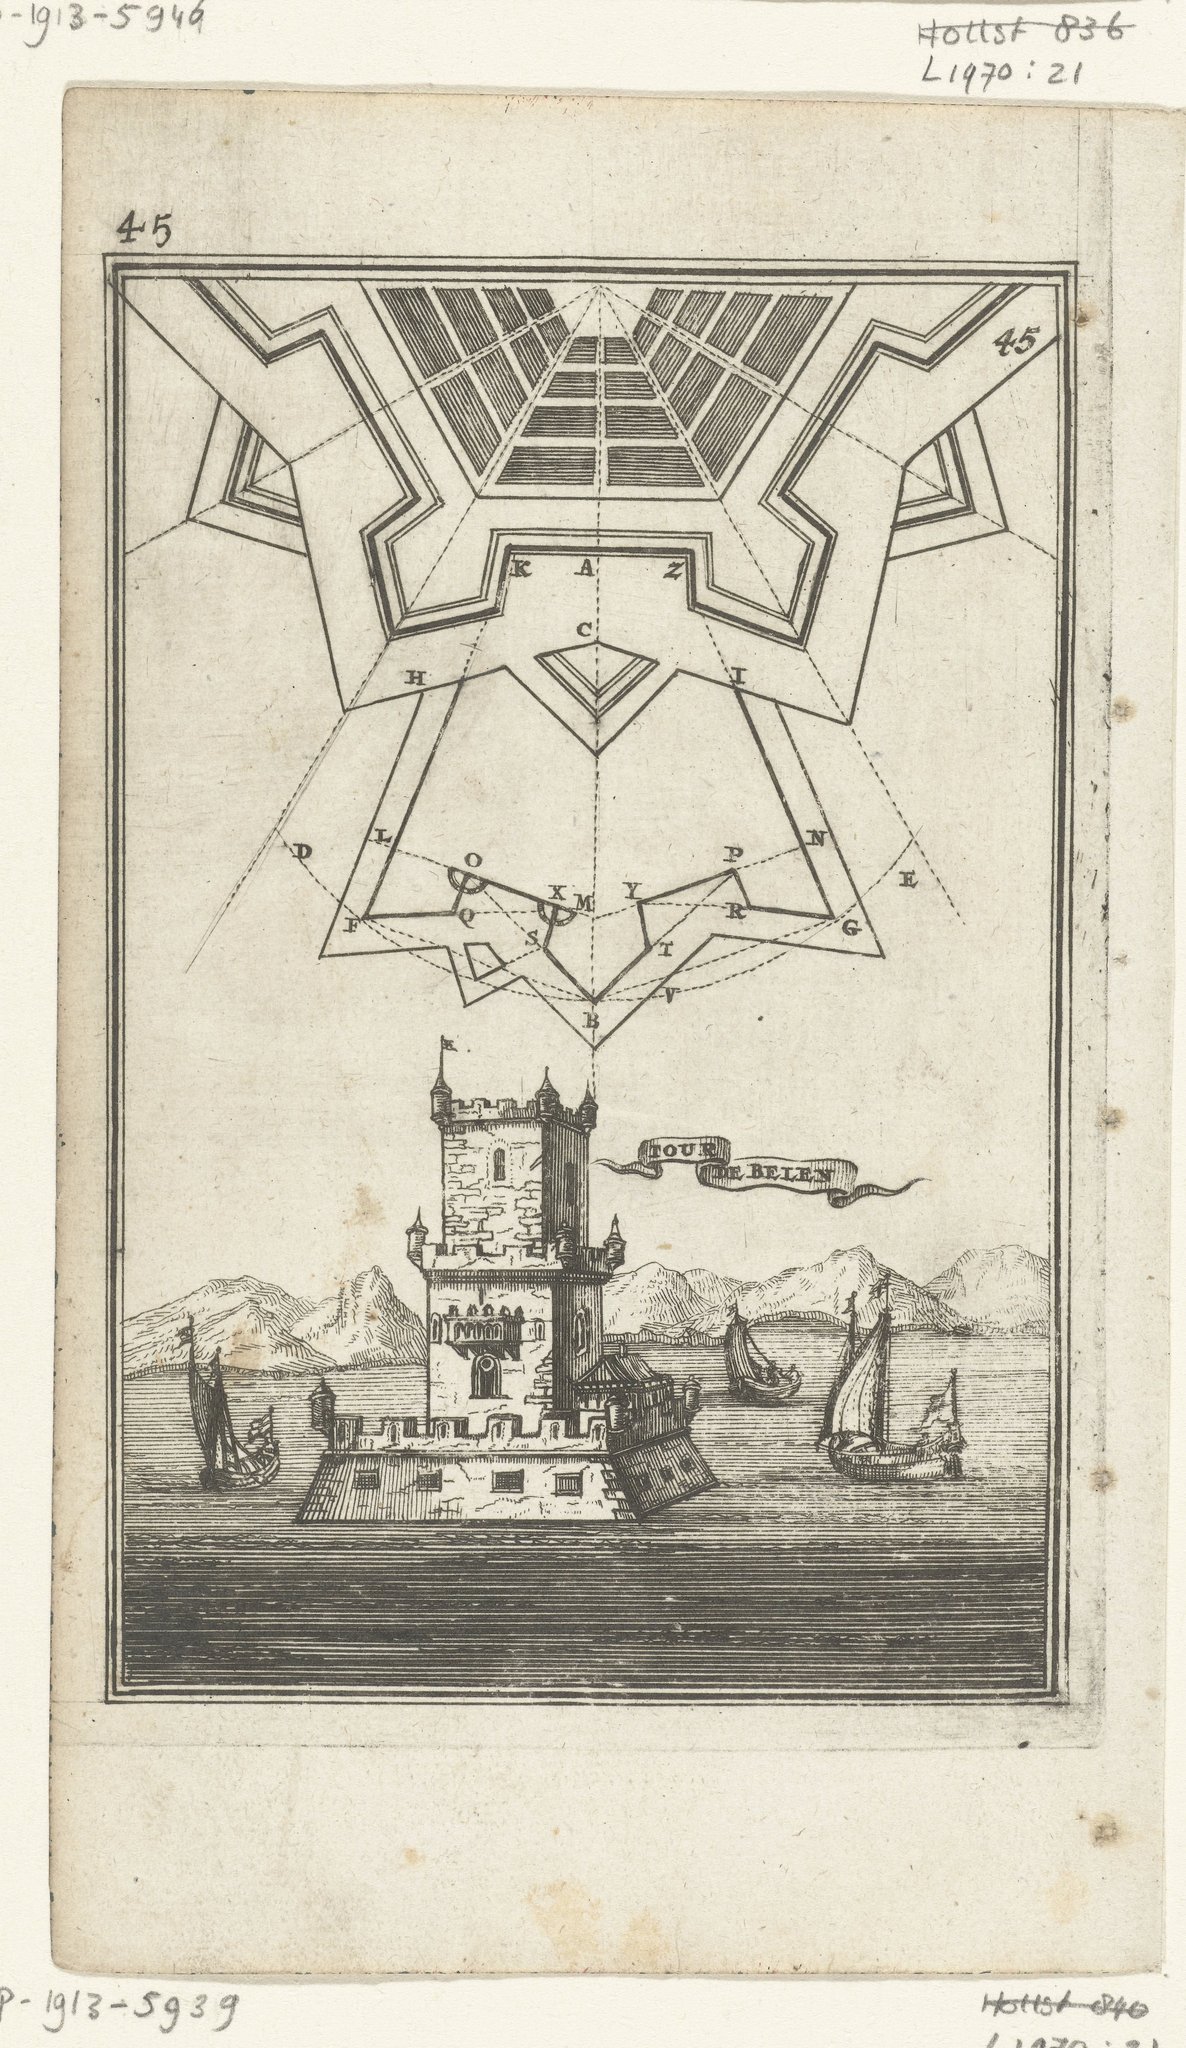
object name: book illustration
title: Illustratie voor 'Den Arbeid van Mars' van Allain Manesson Mallet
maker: romeyn de hooghe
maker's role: draughtsman, goldsmith, painter, print maker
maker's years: 1645-1708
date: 1672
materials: paper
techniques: etching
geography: amsterdam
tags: landscape with tower or castle, fortifications, military engineering, coast, mathematics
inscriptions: collector's mark: Lugt 2228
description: Grondplan voor een deel van een vesting, fort of versterking. Daaronder een gezicht op een toren voor een kust (toren van Belém bij Lissabon). In de hoek rechts- en linksboven het cijfer 45 (= het nummer van de pagina in het boek waartegenover de illustratie geplaatst is).